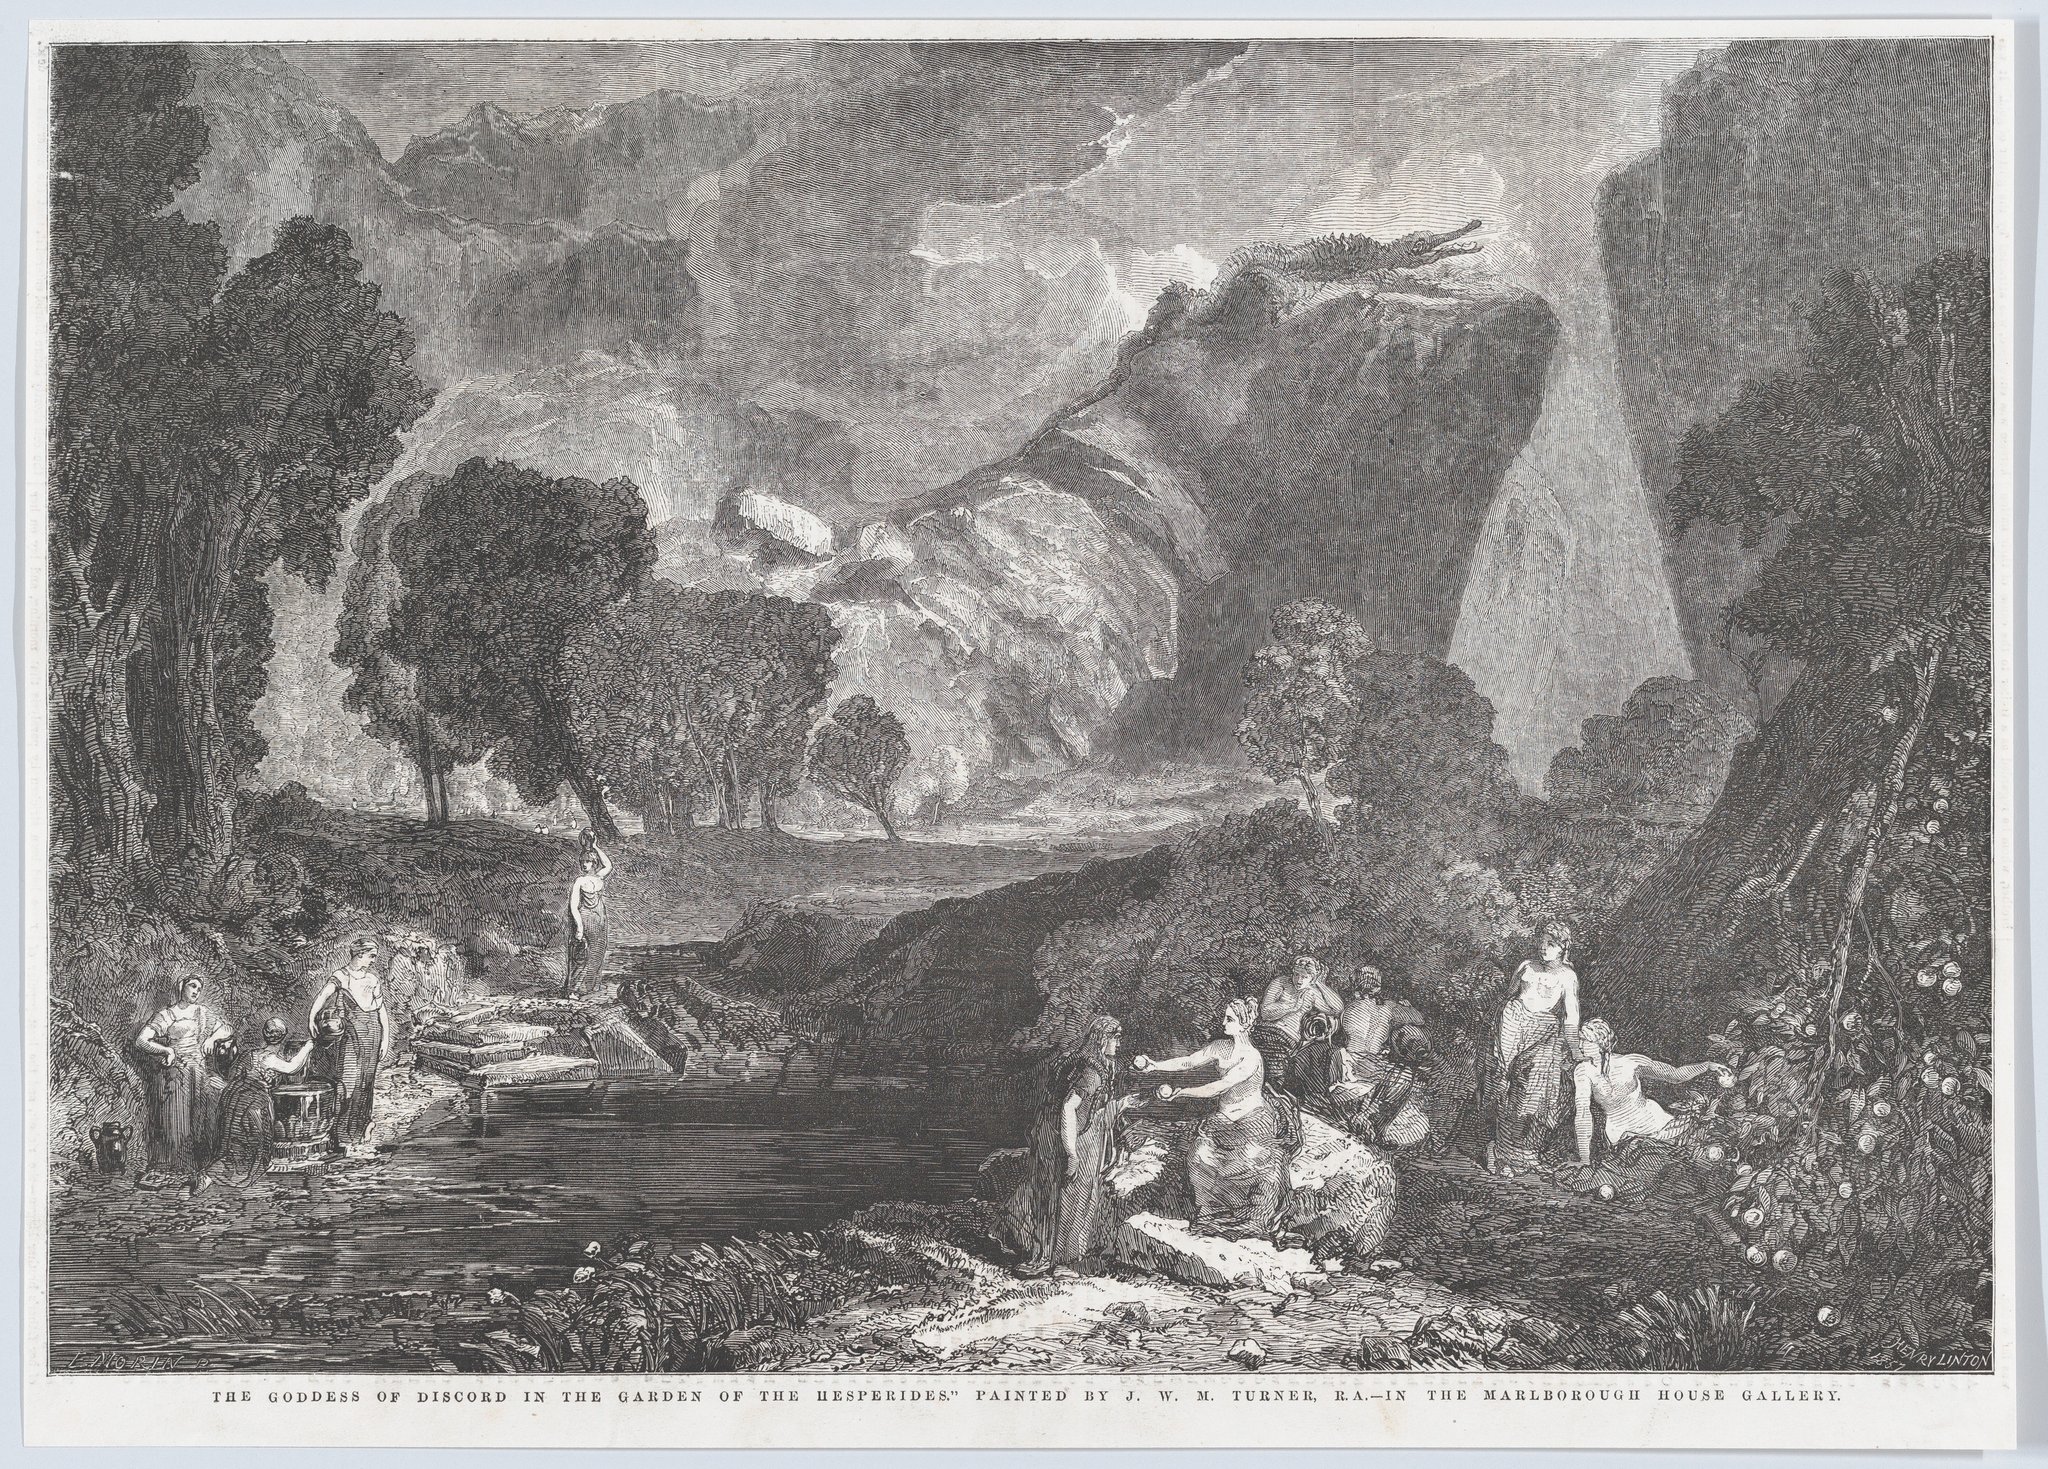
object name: print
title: The Goddess of Discord in the Garden of the Hesperides, from "lllustrated London News"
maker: henry linton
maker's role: engraver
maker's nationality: british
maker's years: 1815-1899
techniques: engraving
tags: gardens,women,goddess,bathing